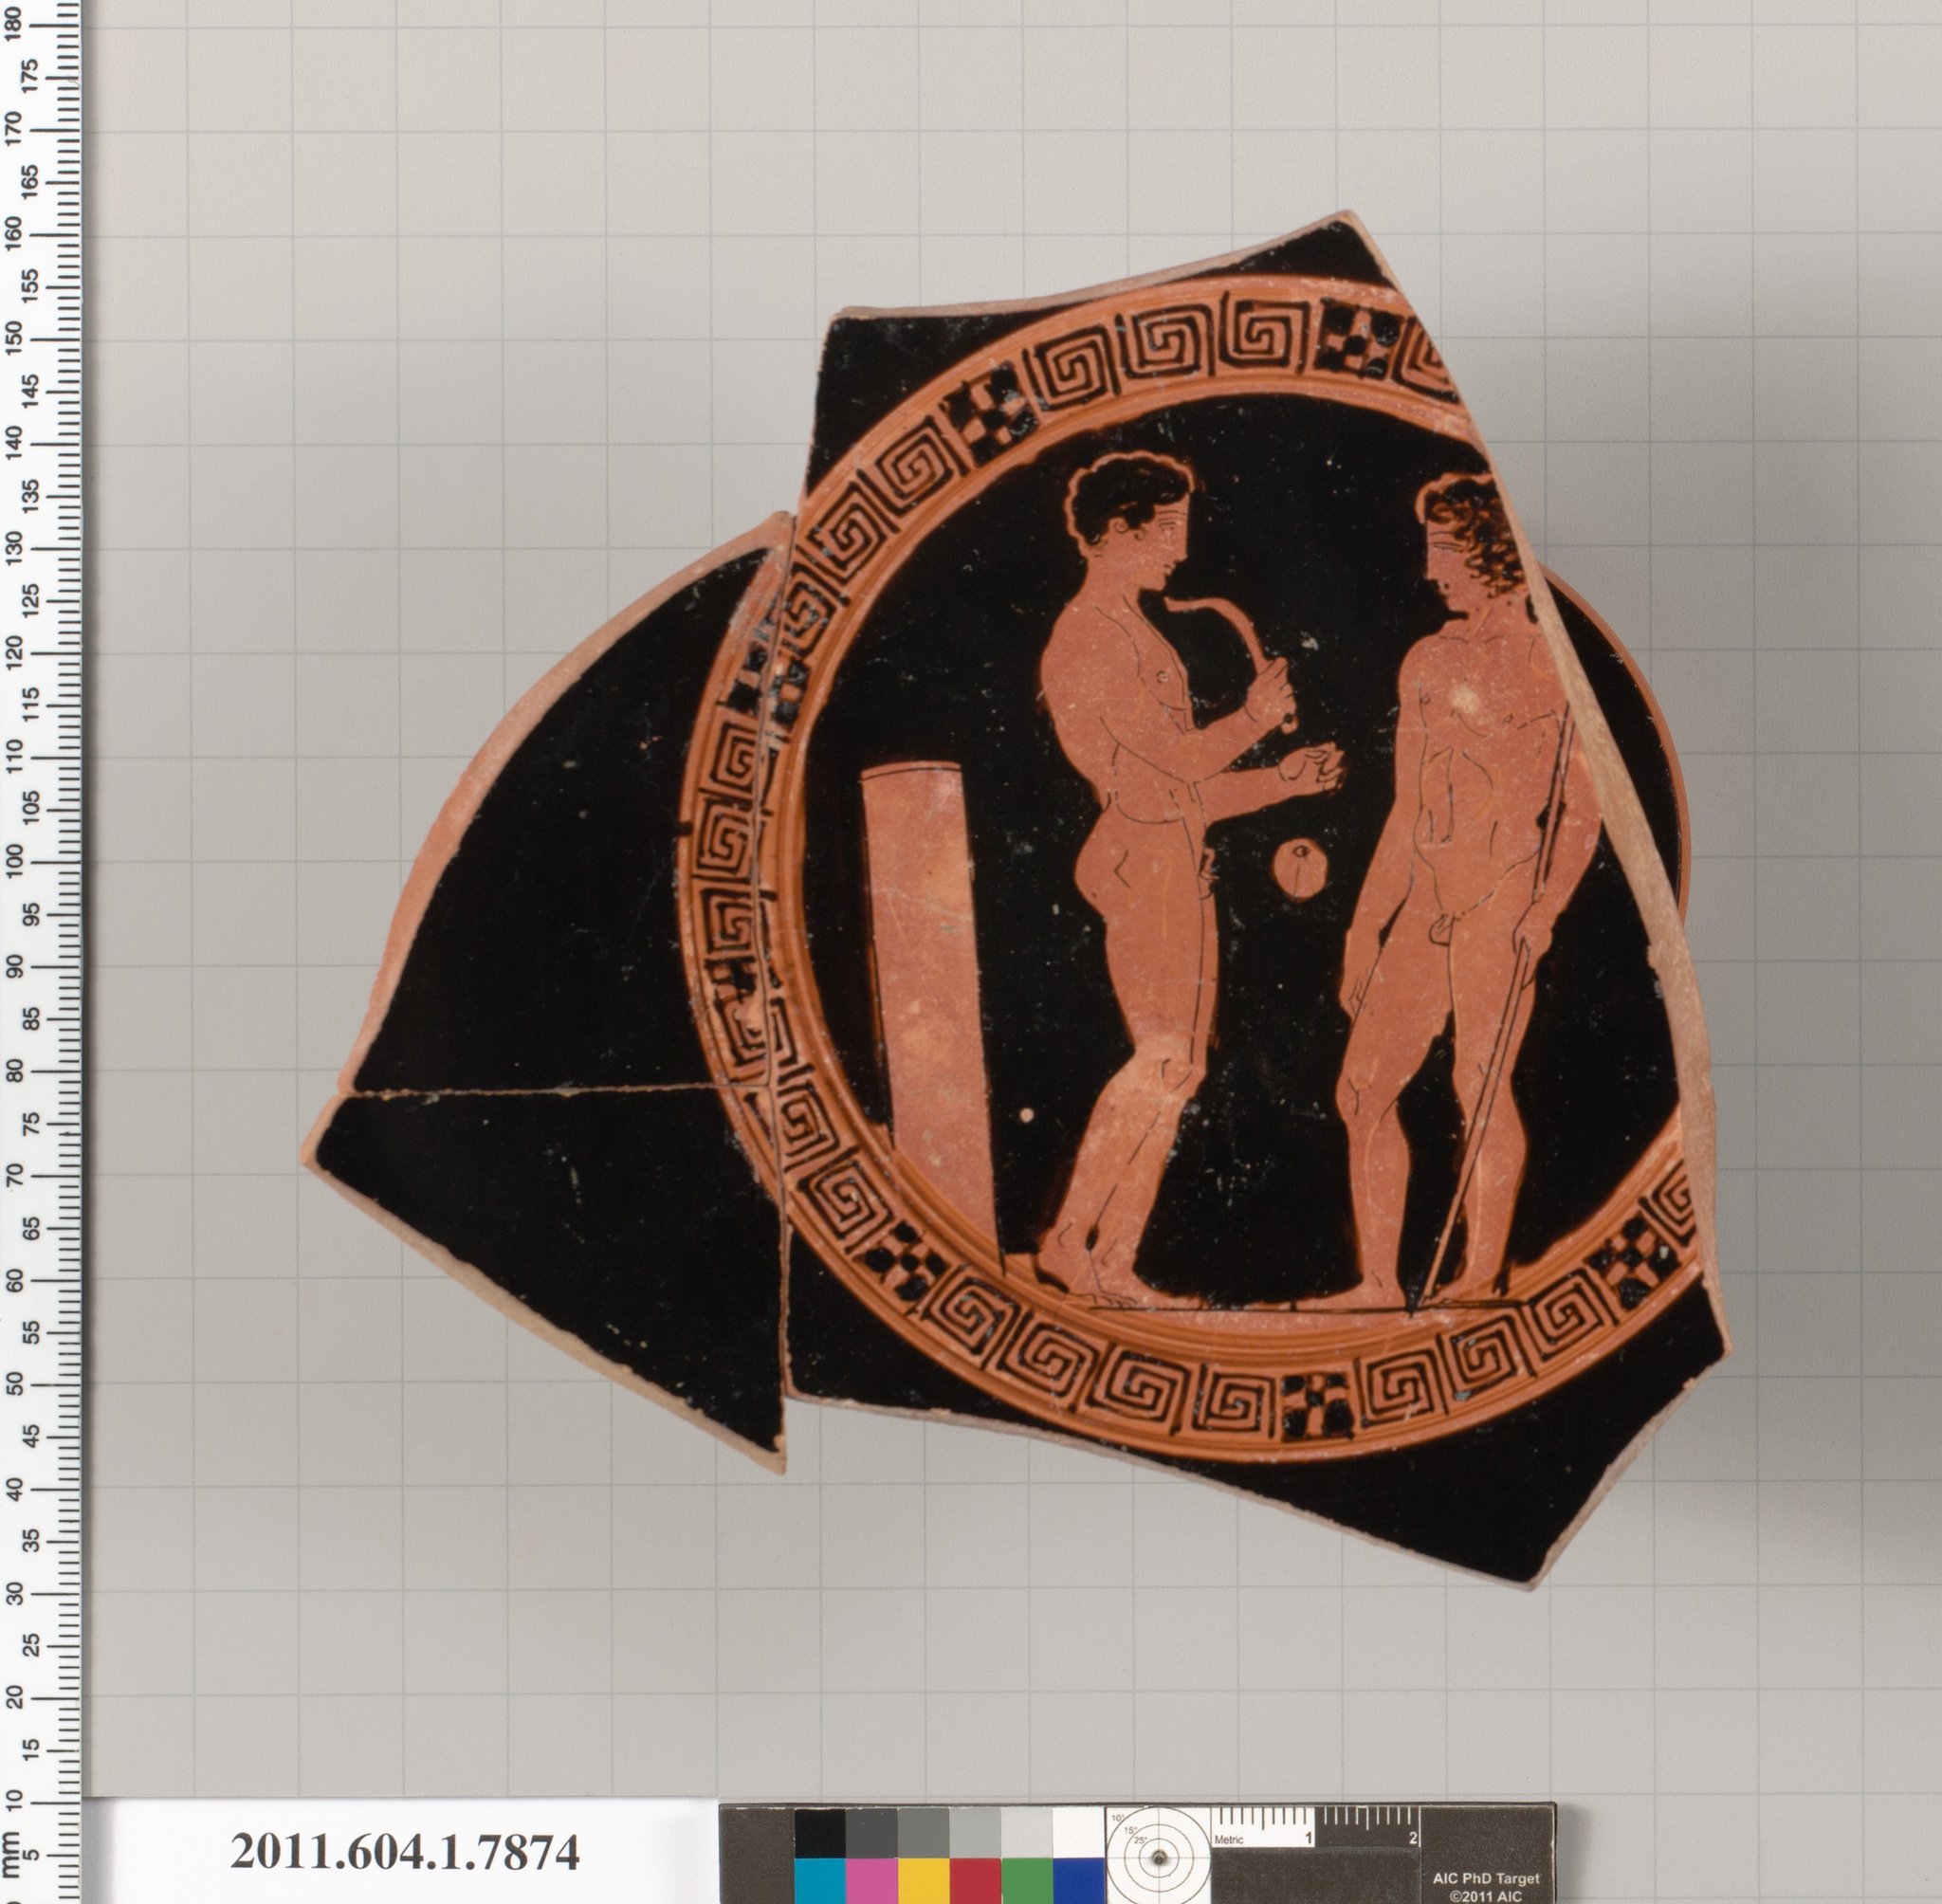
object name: kylix fragment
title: Terracotta fragment of a kylix (drinking cup)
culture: greek, attic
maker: aison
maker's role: artist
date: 420 BCE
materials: terracotta